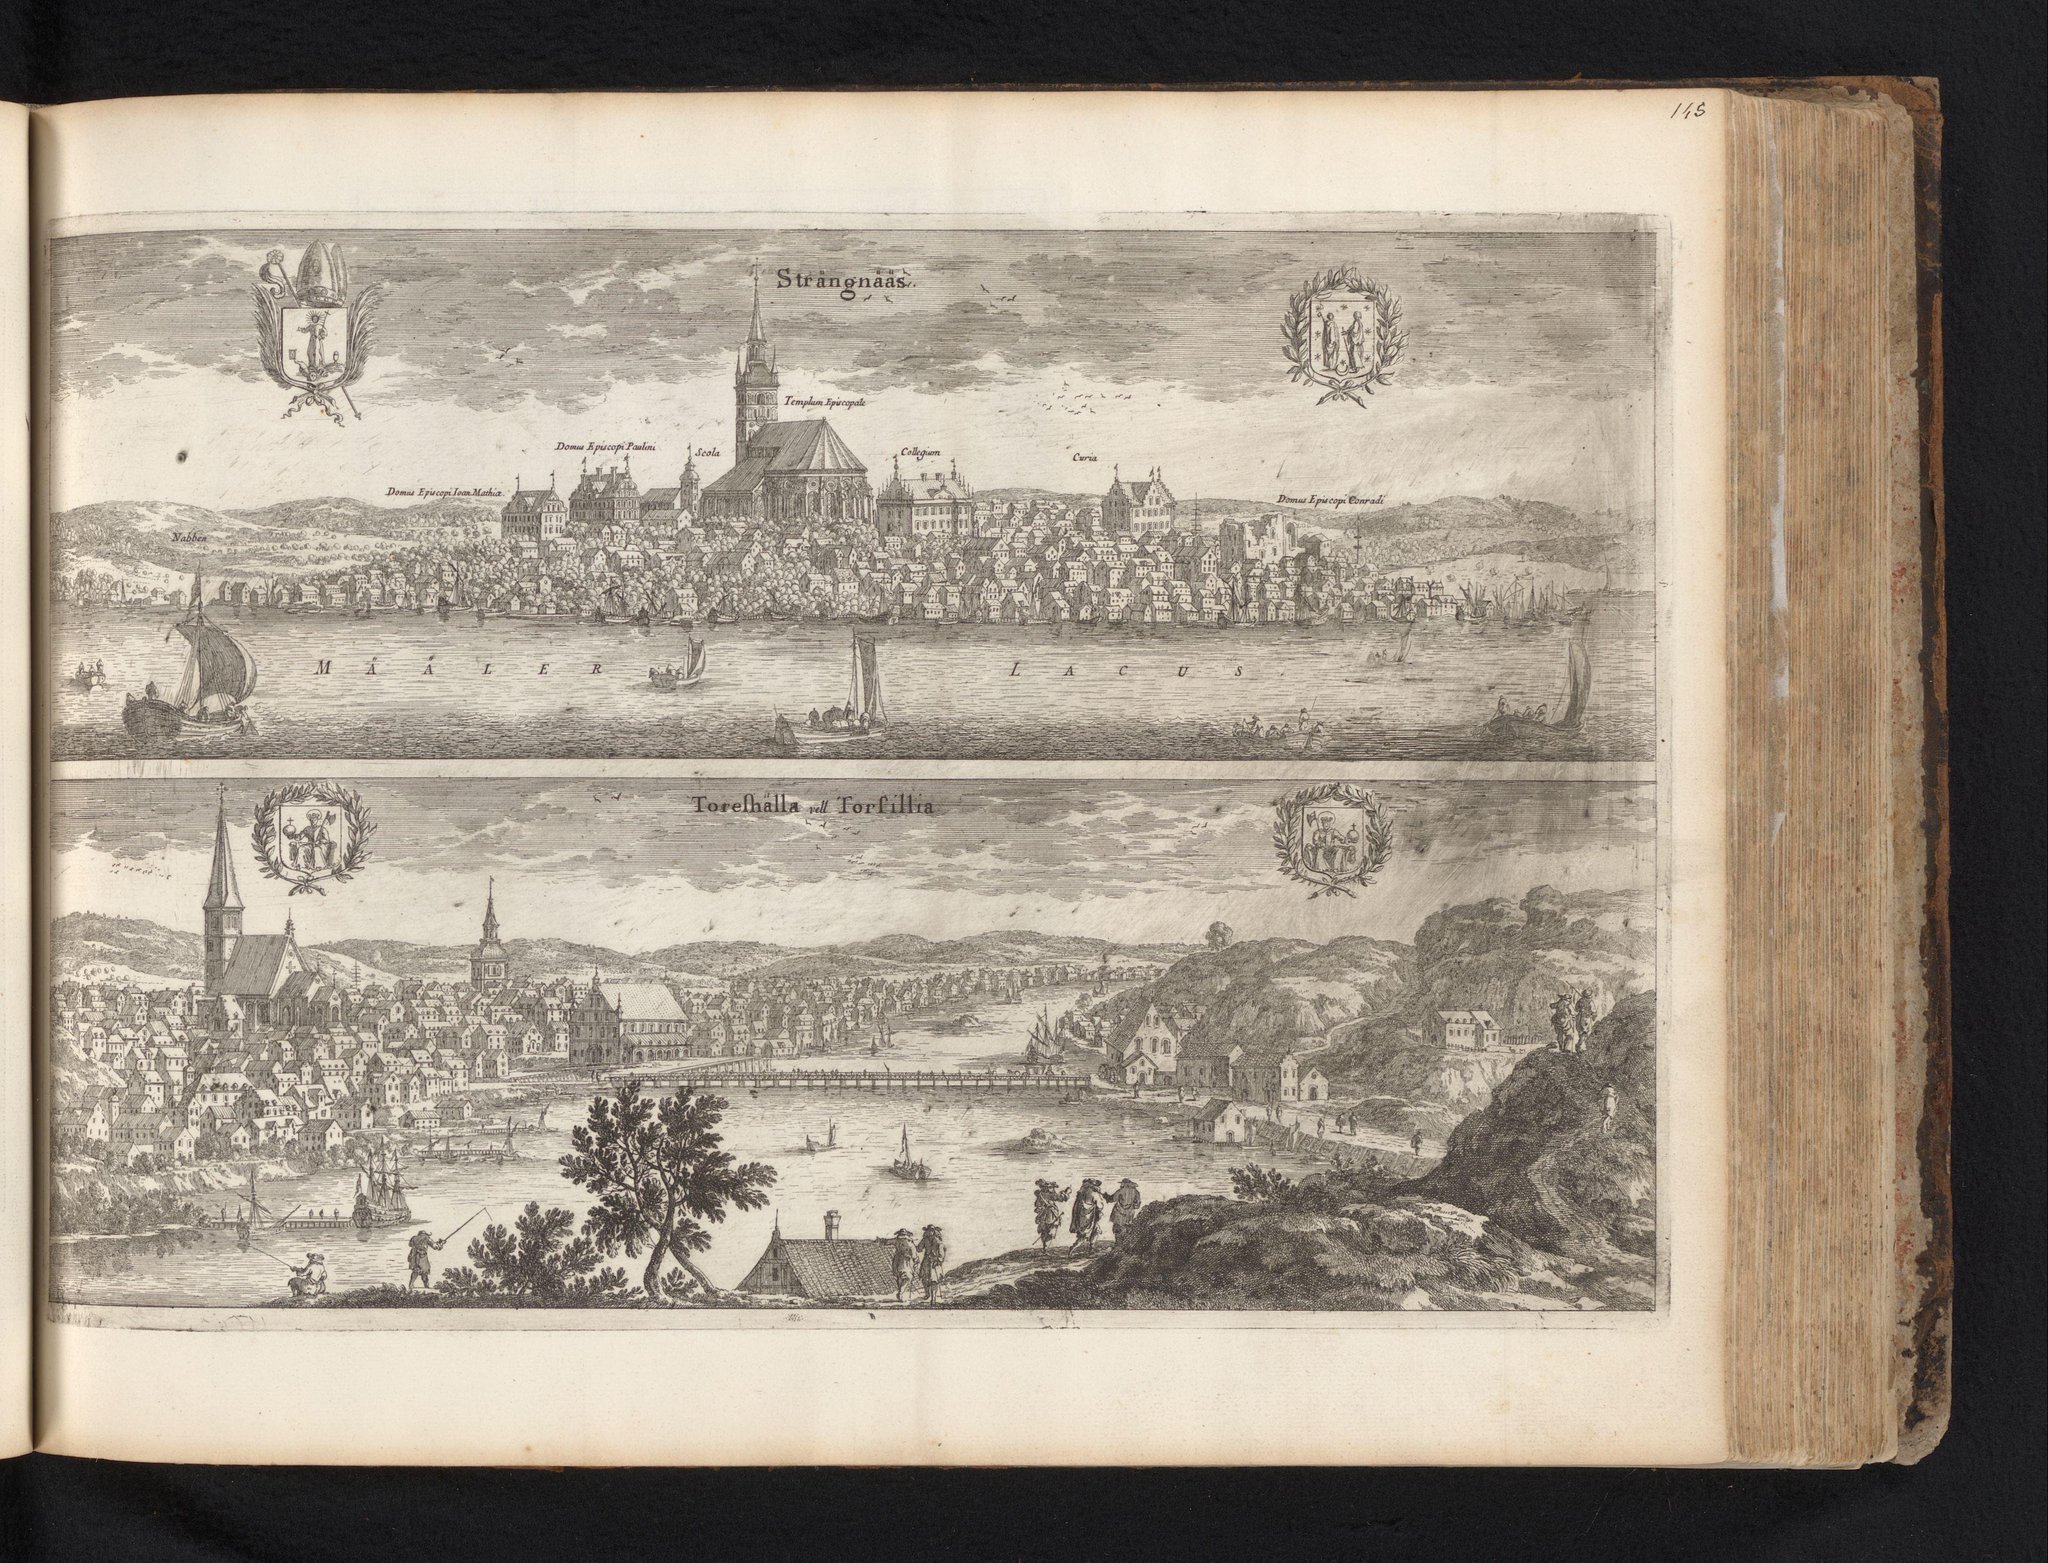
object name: album leaf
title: Strängnääs / Toreshälla vell Torsilia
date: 1670-1674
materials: paper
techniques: etching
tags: city-view in general; 'veduta'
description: Kungliga Biblioteket, 'Suecia': http://www.kb.se/samlingarna/Kartor-bilder/Suecia-antiqua/ (geraadpleegd november 2016).